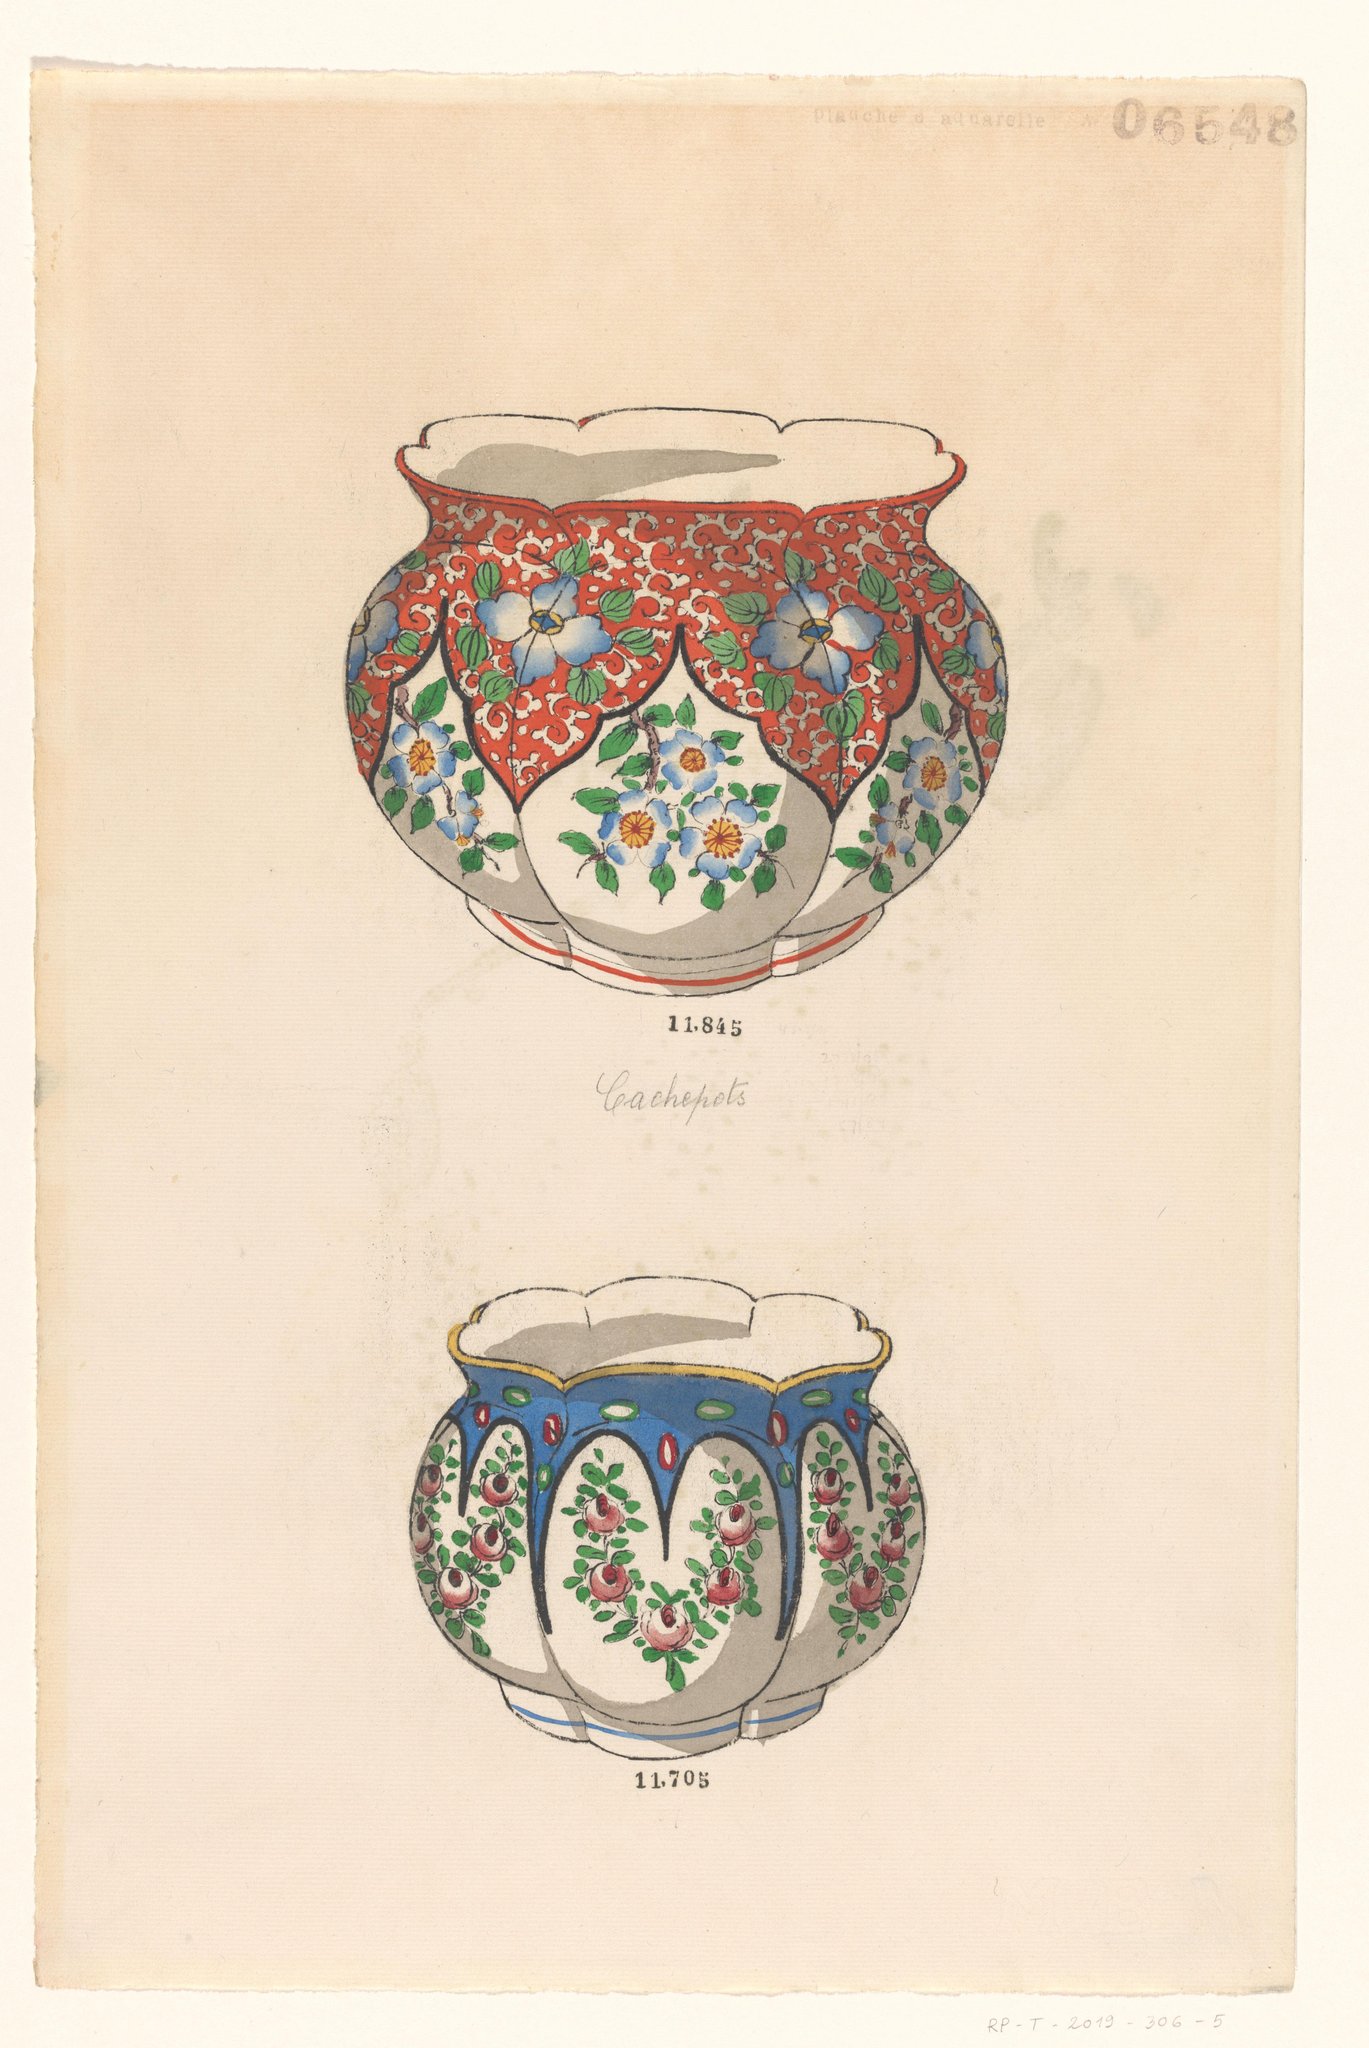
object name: drawing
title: Zes bladen uit een produktiecatalogus van een ceramiekmanufactuur of -handelaar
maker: Anonymous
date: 1900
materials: ink, paper, watercolor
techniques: brush, pen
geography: france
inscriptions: stamp: ‘Planche d'aquarelle No 06548’, stamp, inscription: ‘Cachepots’, watermark: ‘MBM’